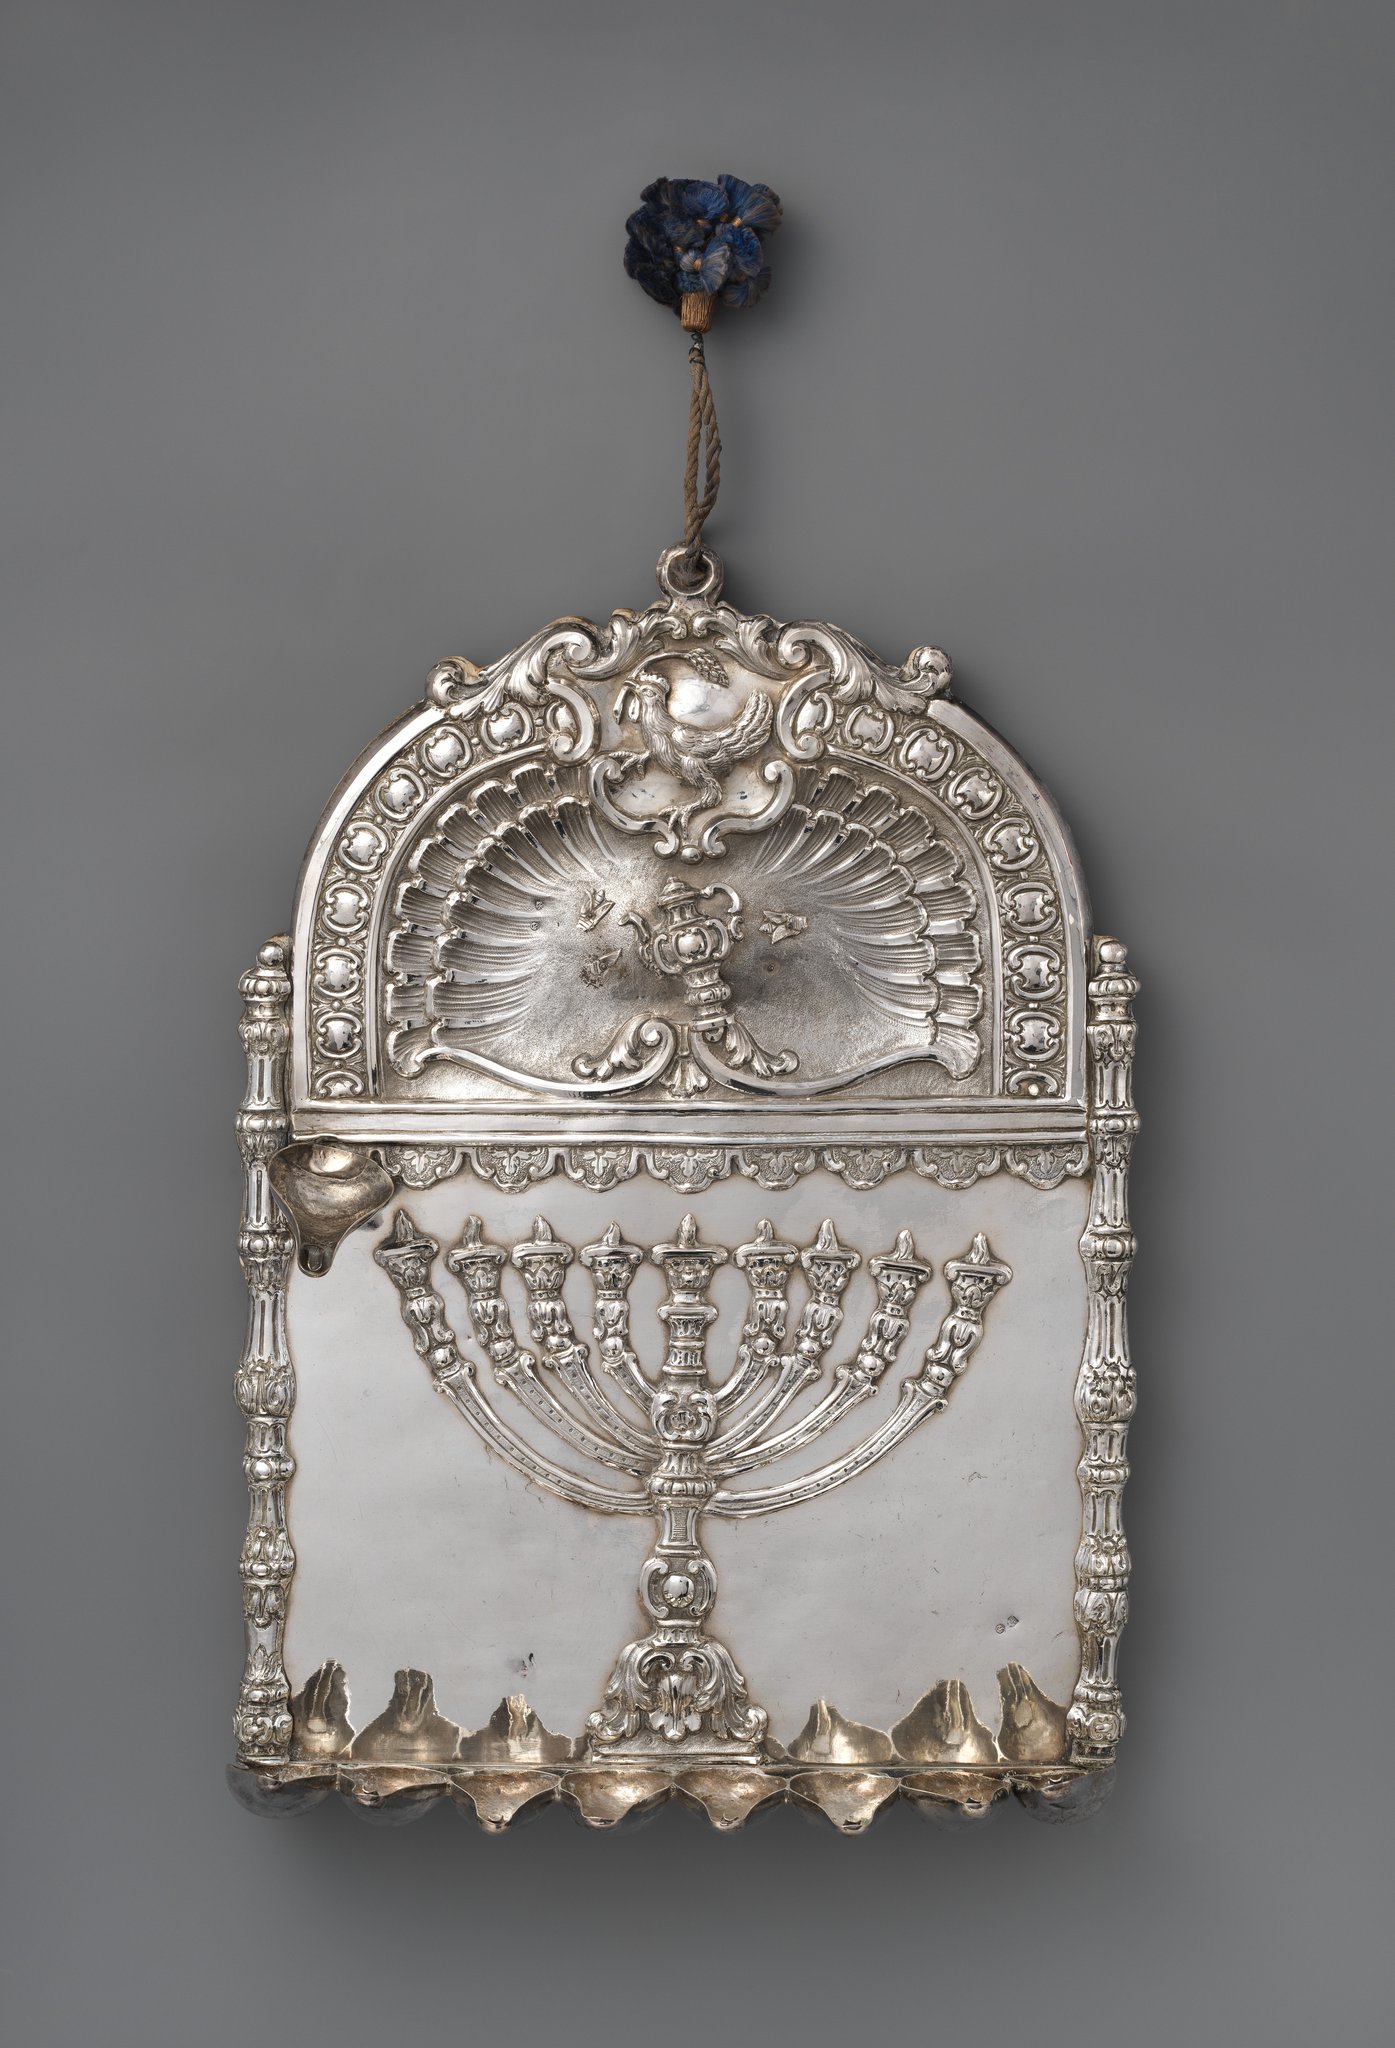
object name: hanukkah lamp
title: Baraffael Family Hanukkah Lamp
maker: gaspare vanneschi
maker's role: maker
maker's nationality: italian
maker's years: 1758-1787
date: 1773-1775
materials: silver, wood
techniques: embossing, engraving